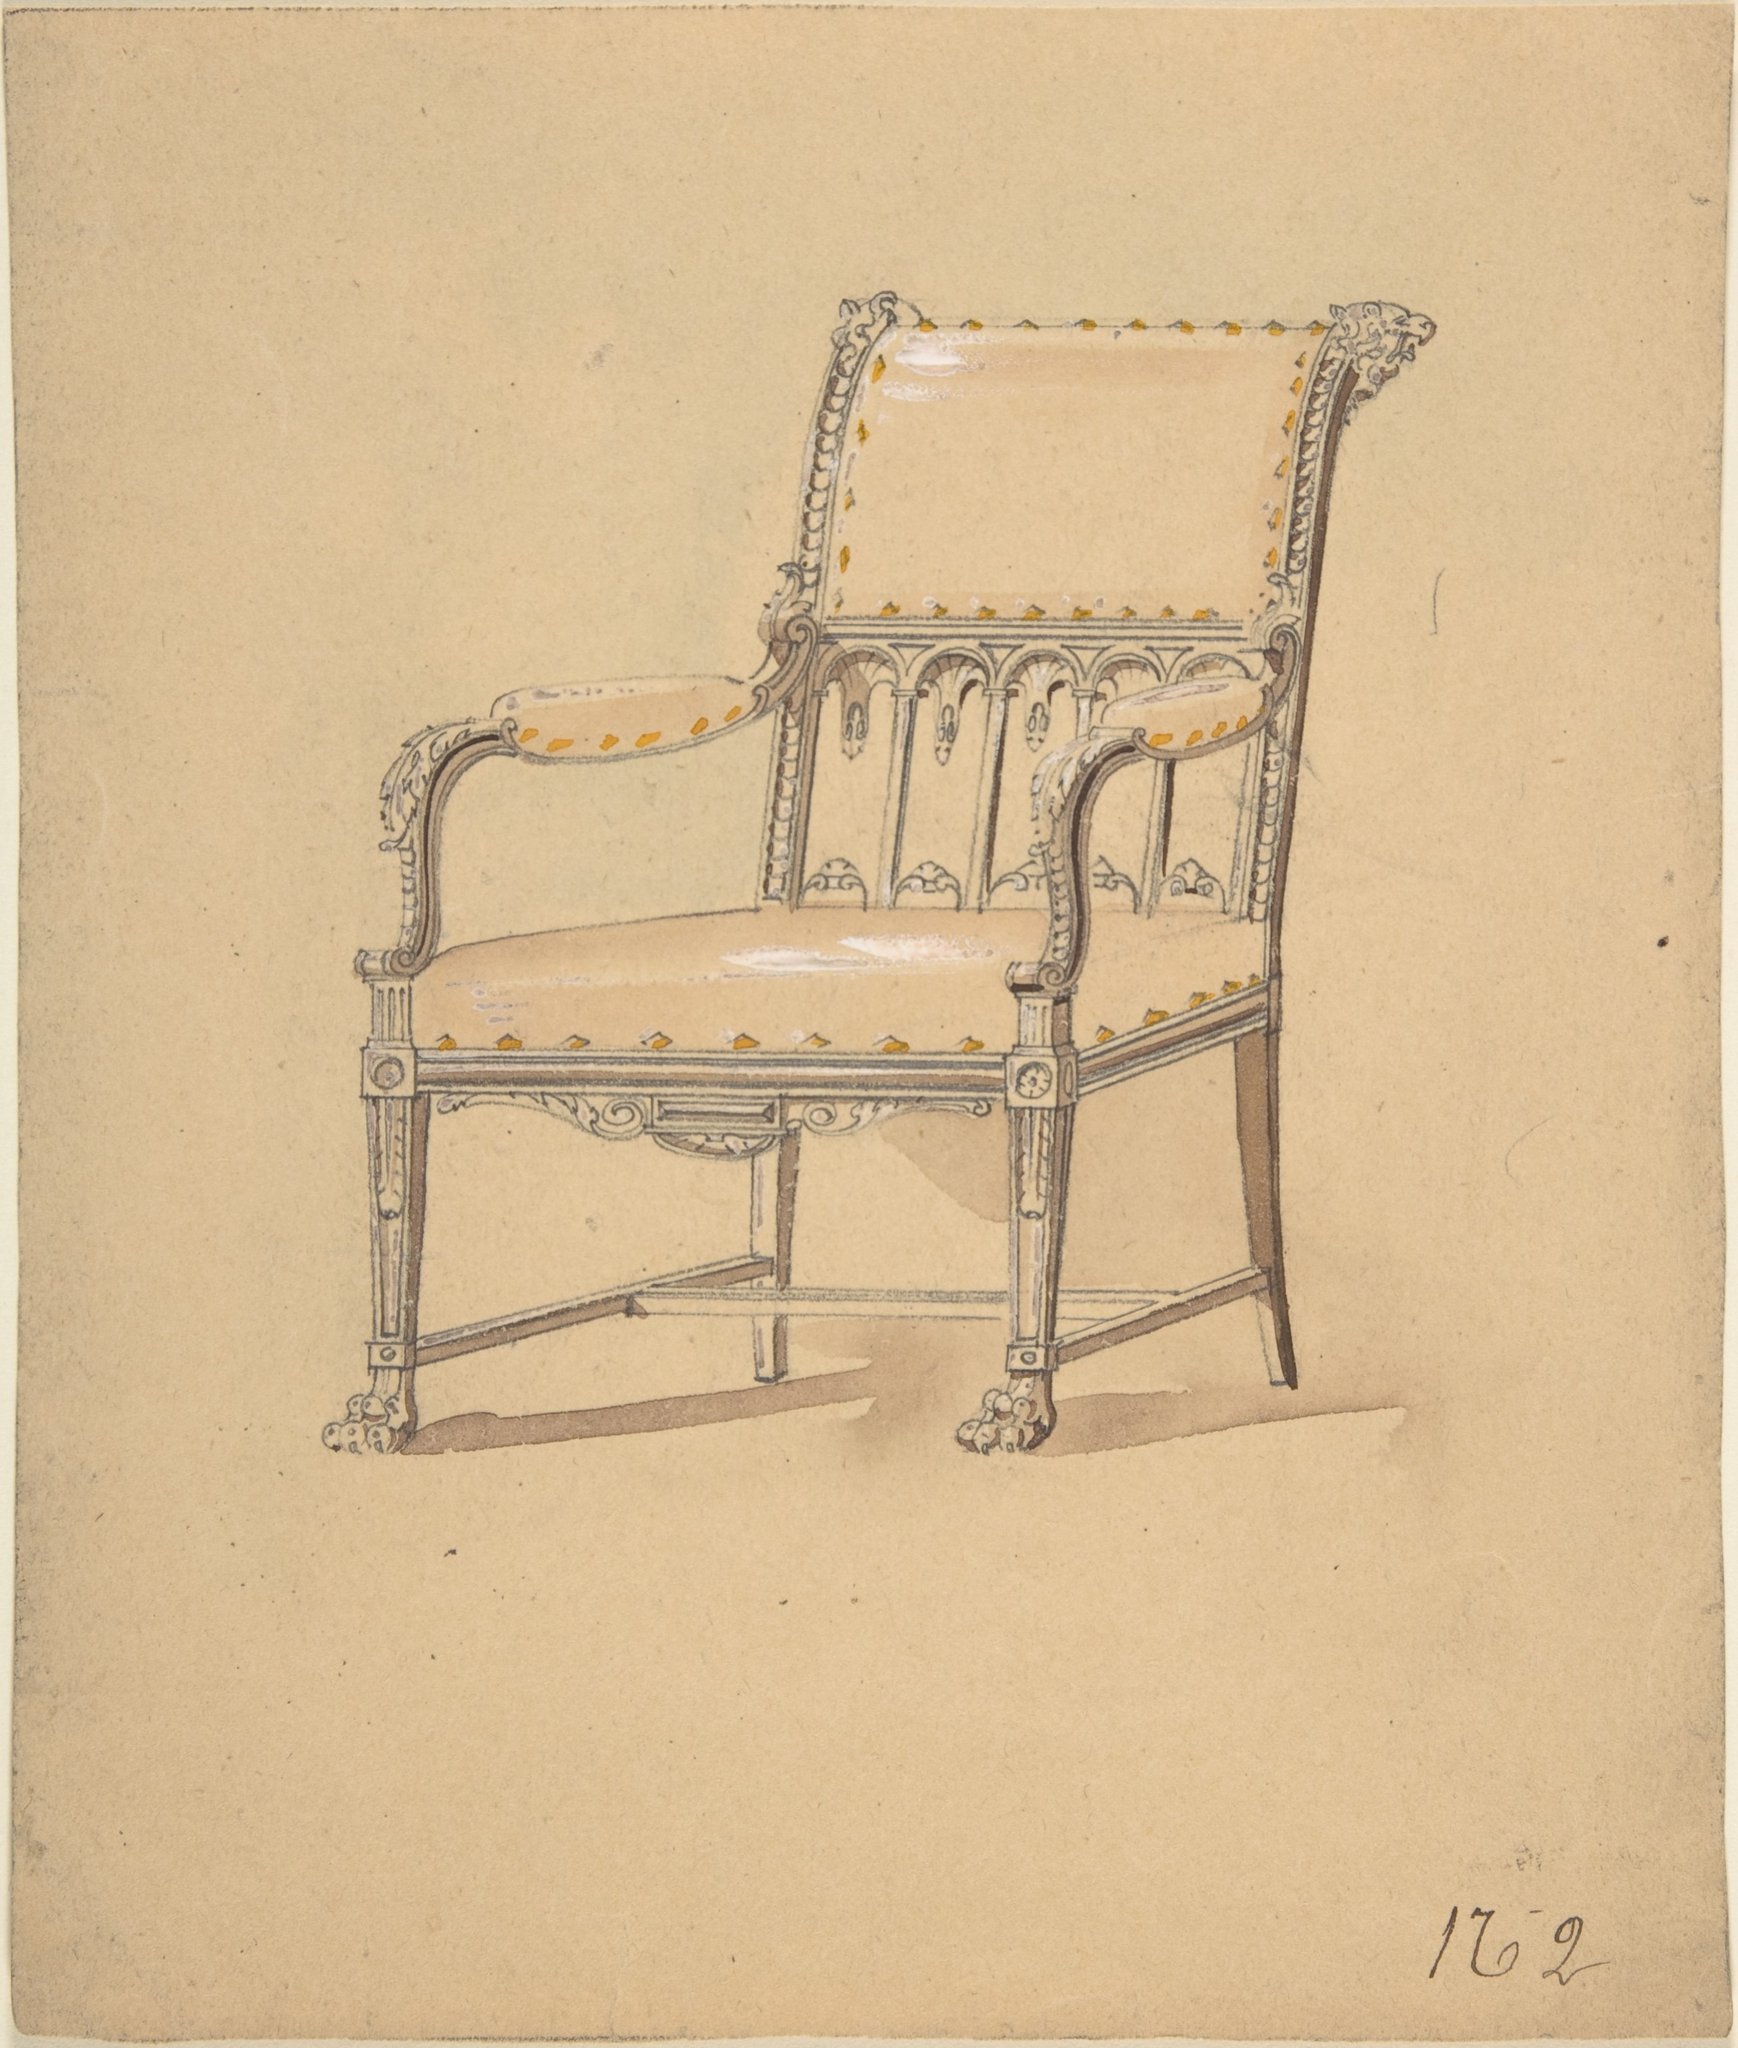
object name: drawing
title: Design for a Chair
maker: anonymous, french, 19th century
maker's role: artist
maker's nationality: french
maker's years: 1800-1900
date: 1801-1900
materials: gouache, graphite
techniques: brush, wash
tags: chairs